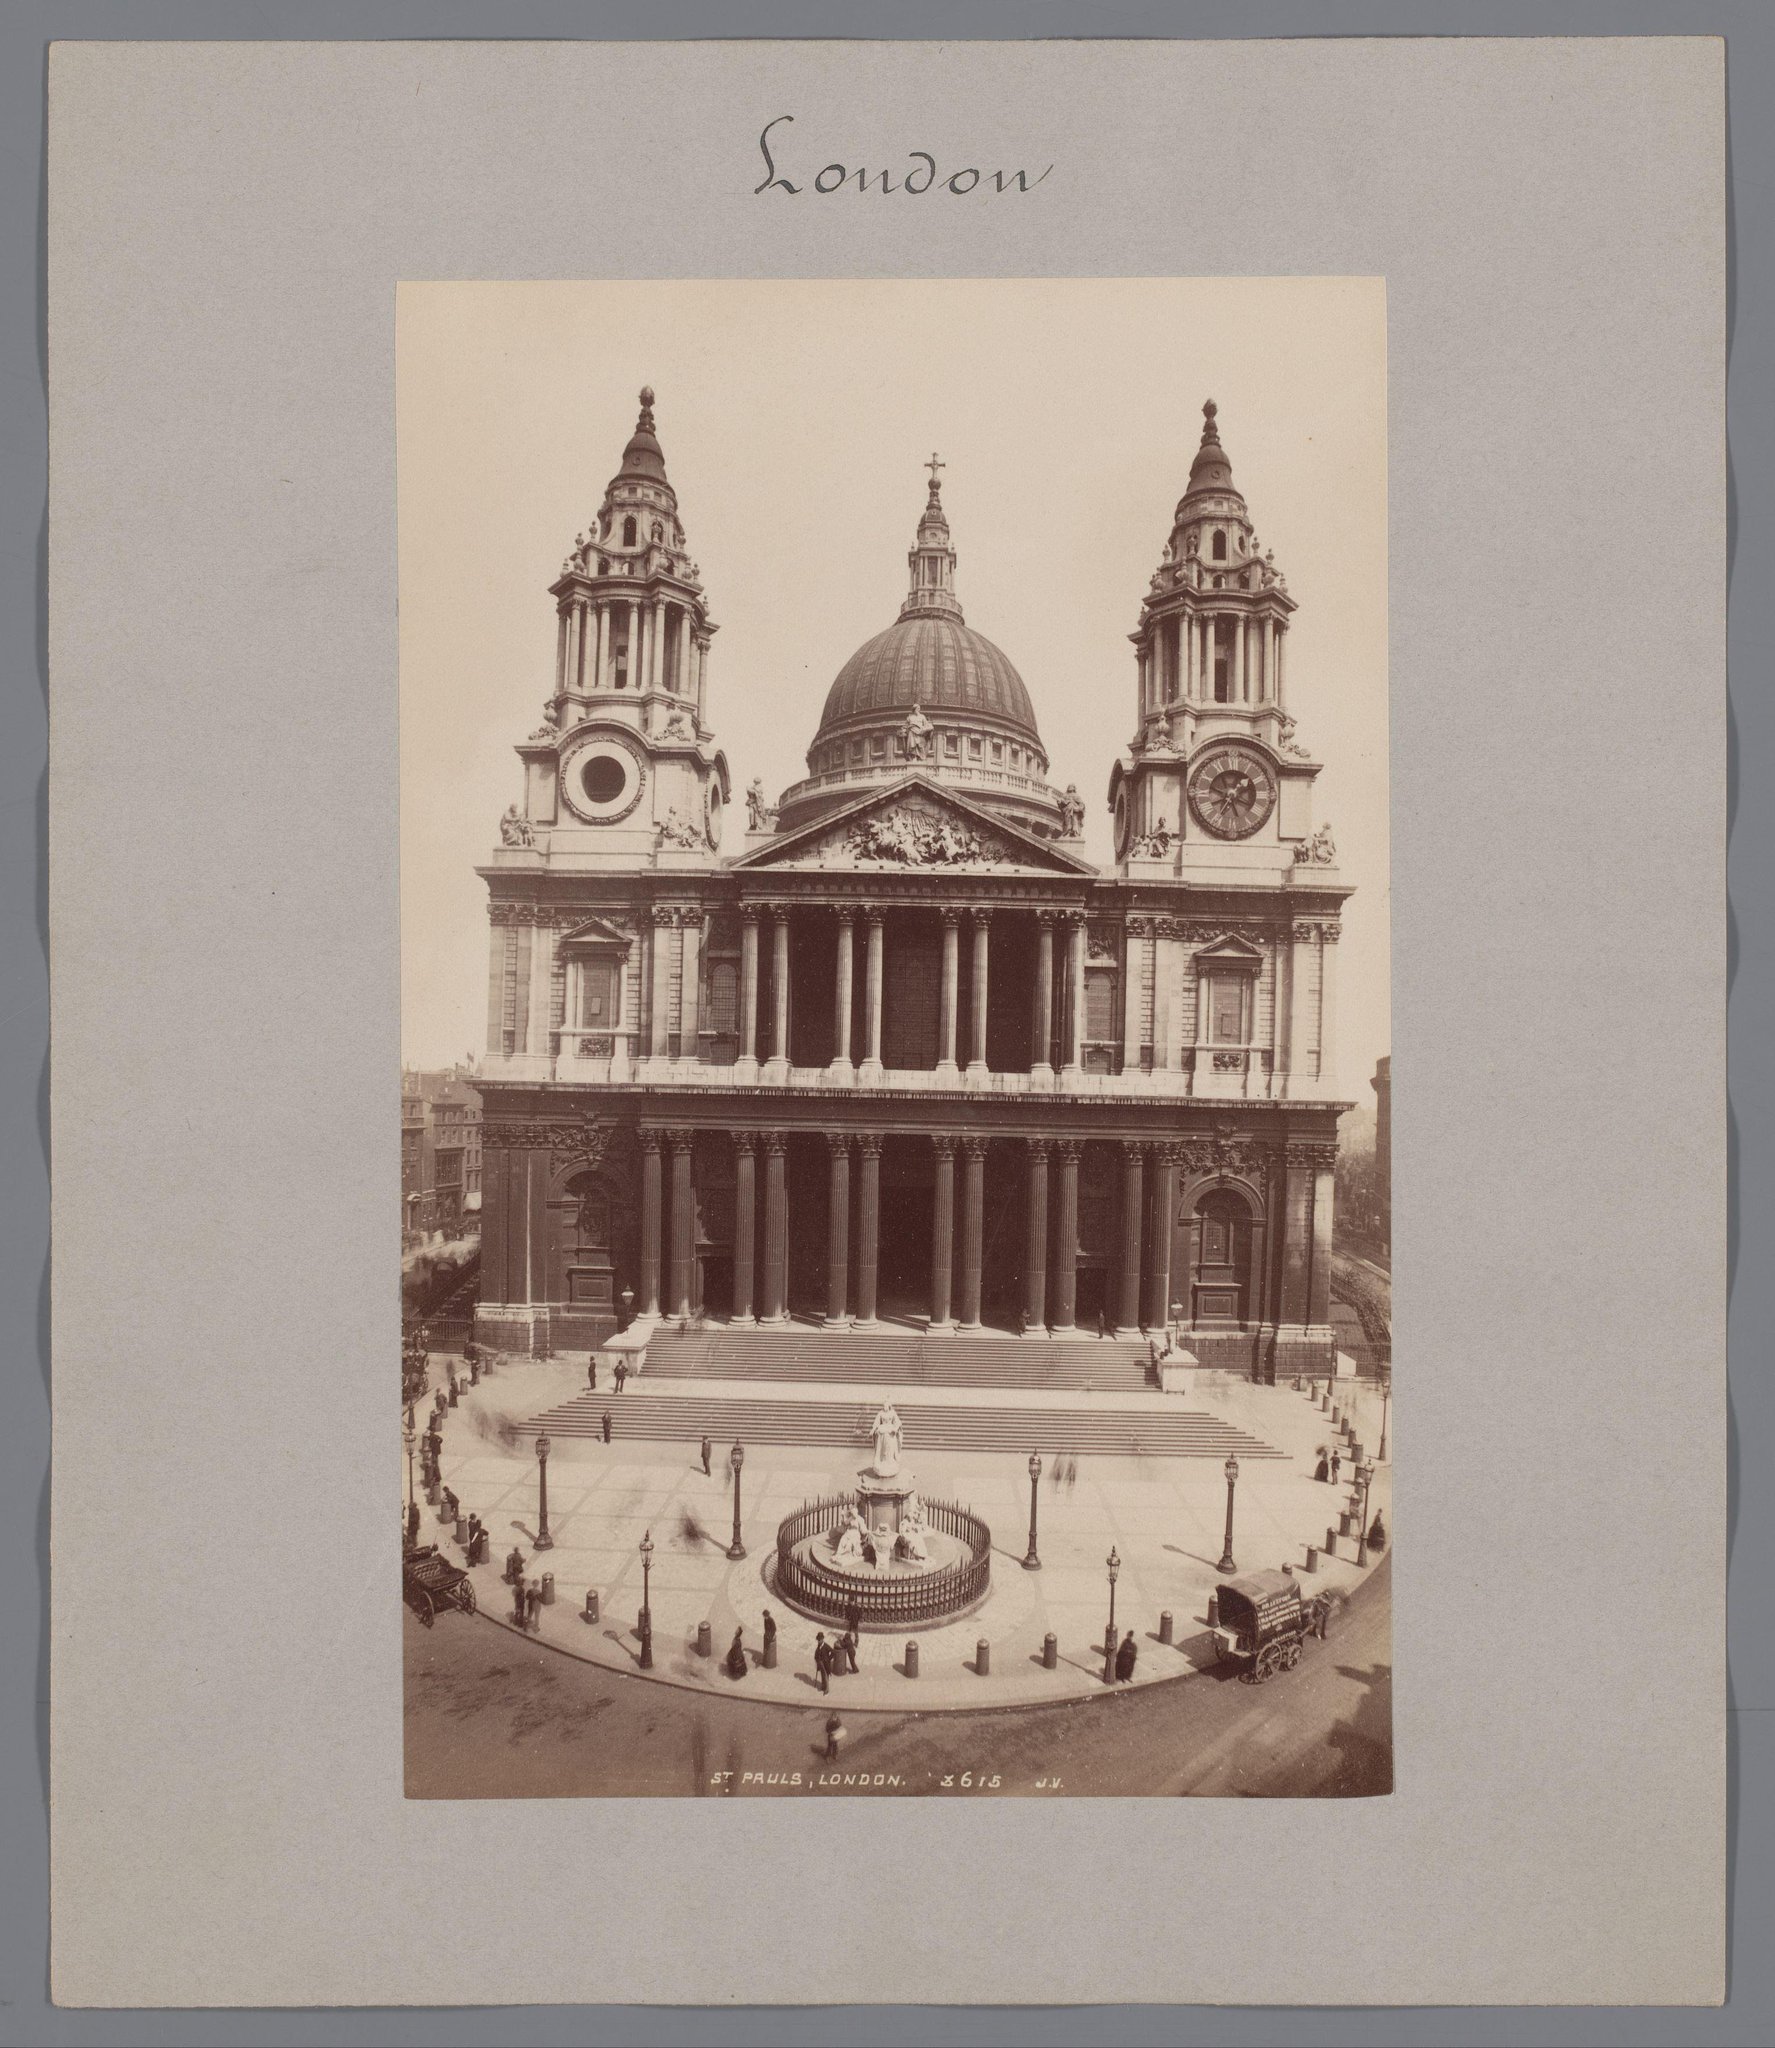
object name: photograph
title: St. Paul's Cathedral, Londen, Engeland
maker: james valentine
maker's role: fotograaf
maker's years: 1815-1880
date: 1870-1890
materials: cardboard, paper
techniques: albumen print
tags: saint paul's cathedral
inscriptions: inscription: ‘ST PAULS [sic], LONDON. 3613 J.V.’, inscription: ‘London.’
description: Frontaal aanzicht op de westelijke zijde van St. Paul's, vanaf een hoog standpunt. Een aantal mensen en zowel links als rechts een paard en wagen.